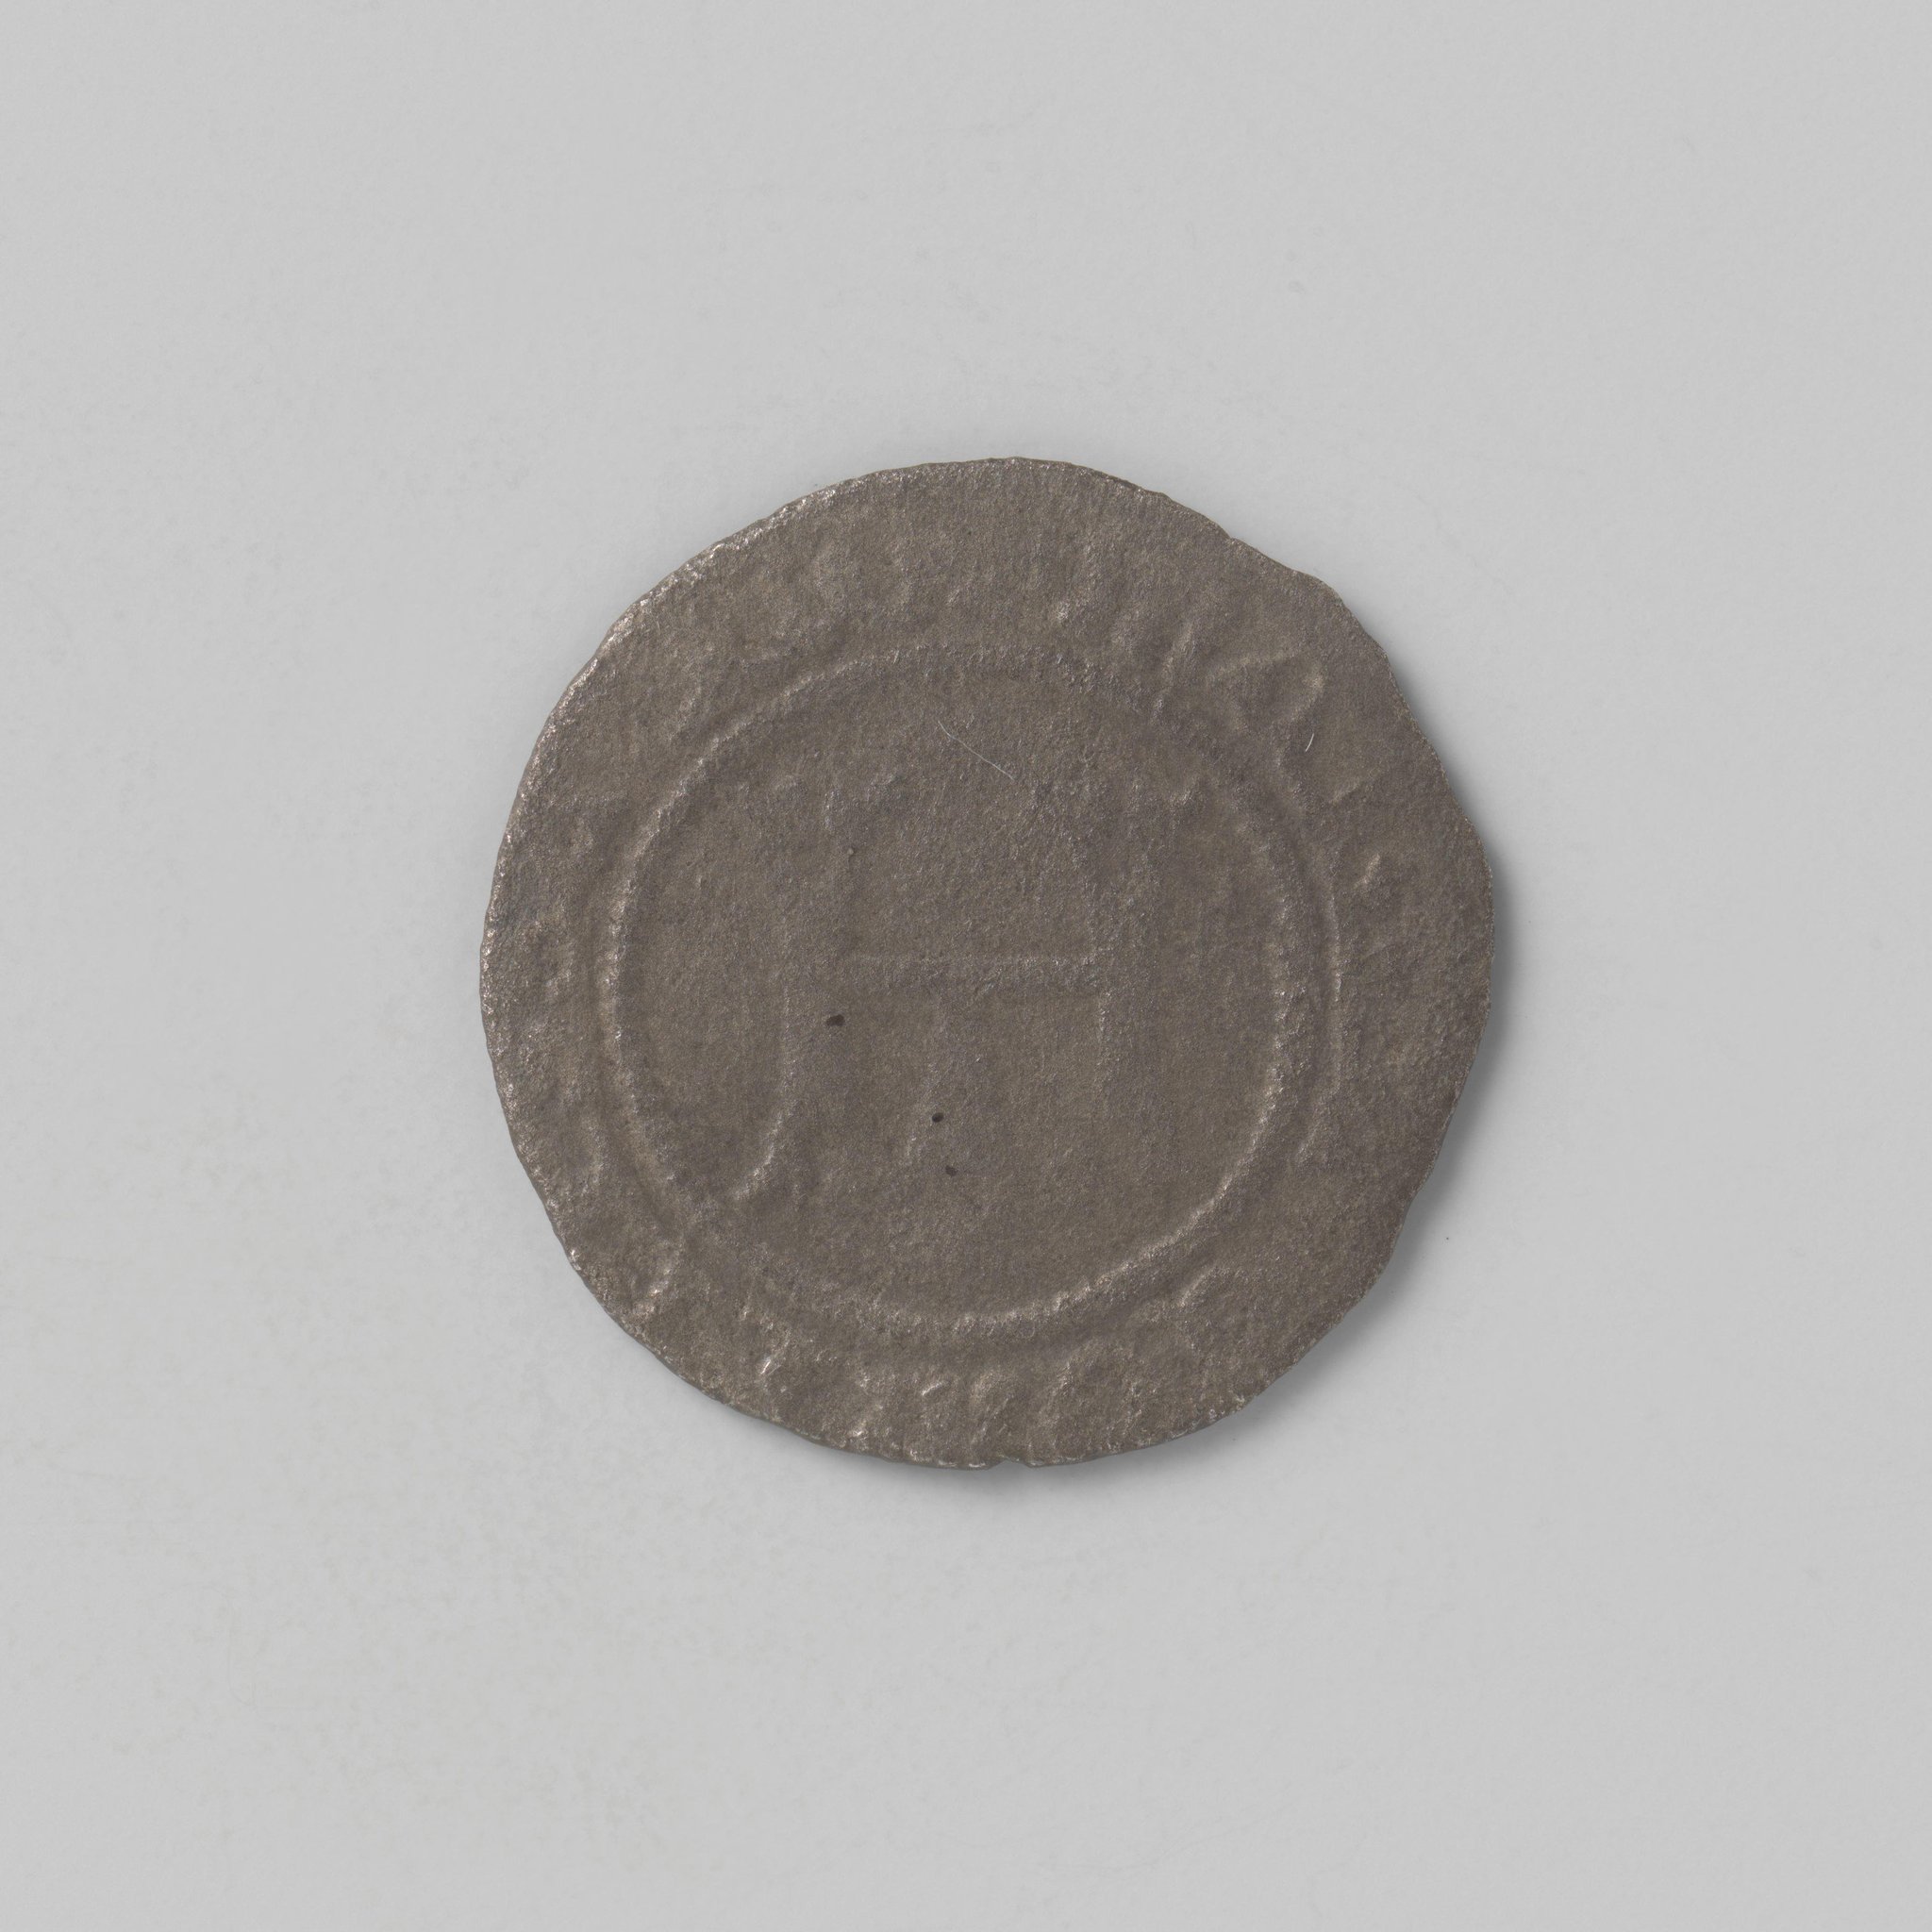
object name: coin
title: Holland, Maria van Bourgondië, halve groot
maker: maria (hertogin van bourgondië)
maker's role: hertogin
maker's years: 1457-1482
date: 1478-1482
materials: silver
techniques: striking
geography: dordrecht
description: Zilveren munt. Voorzijde: rechthoekige letter M. Keerzijde: kort gebloemd kruis.